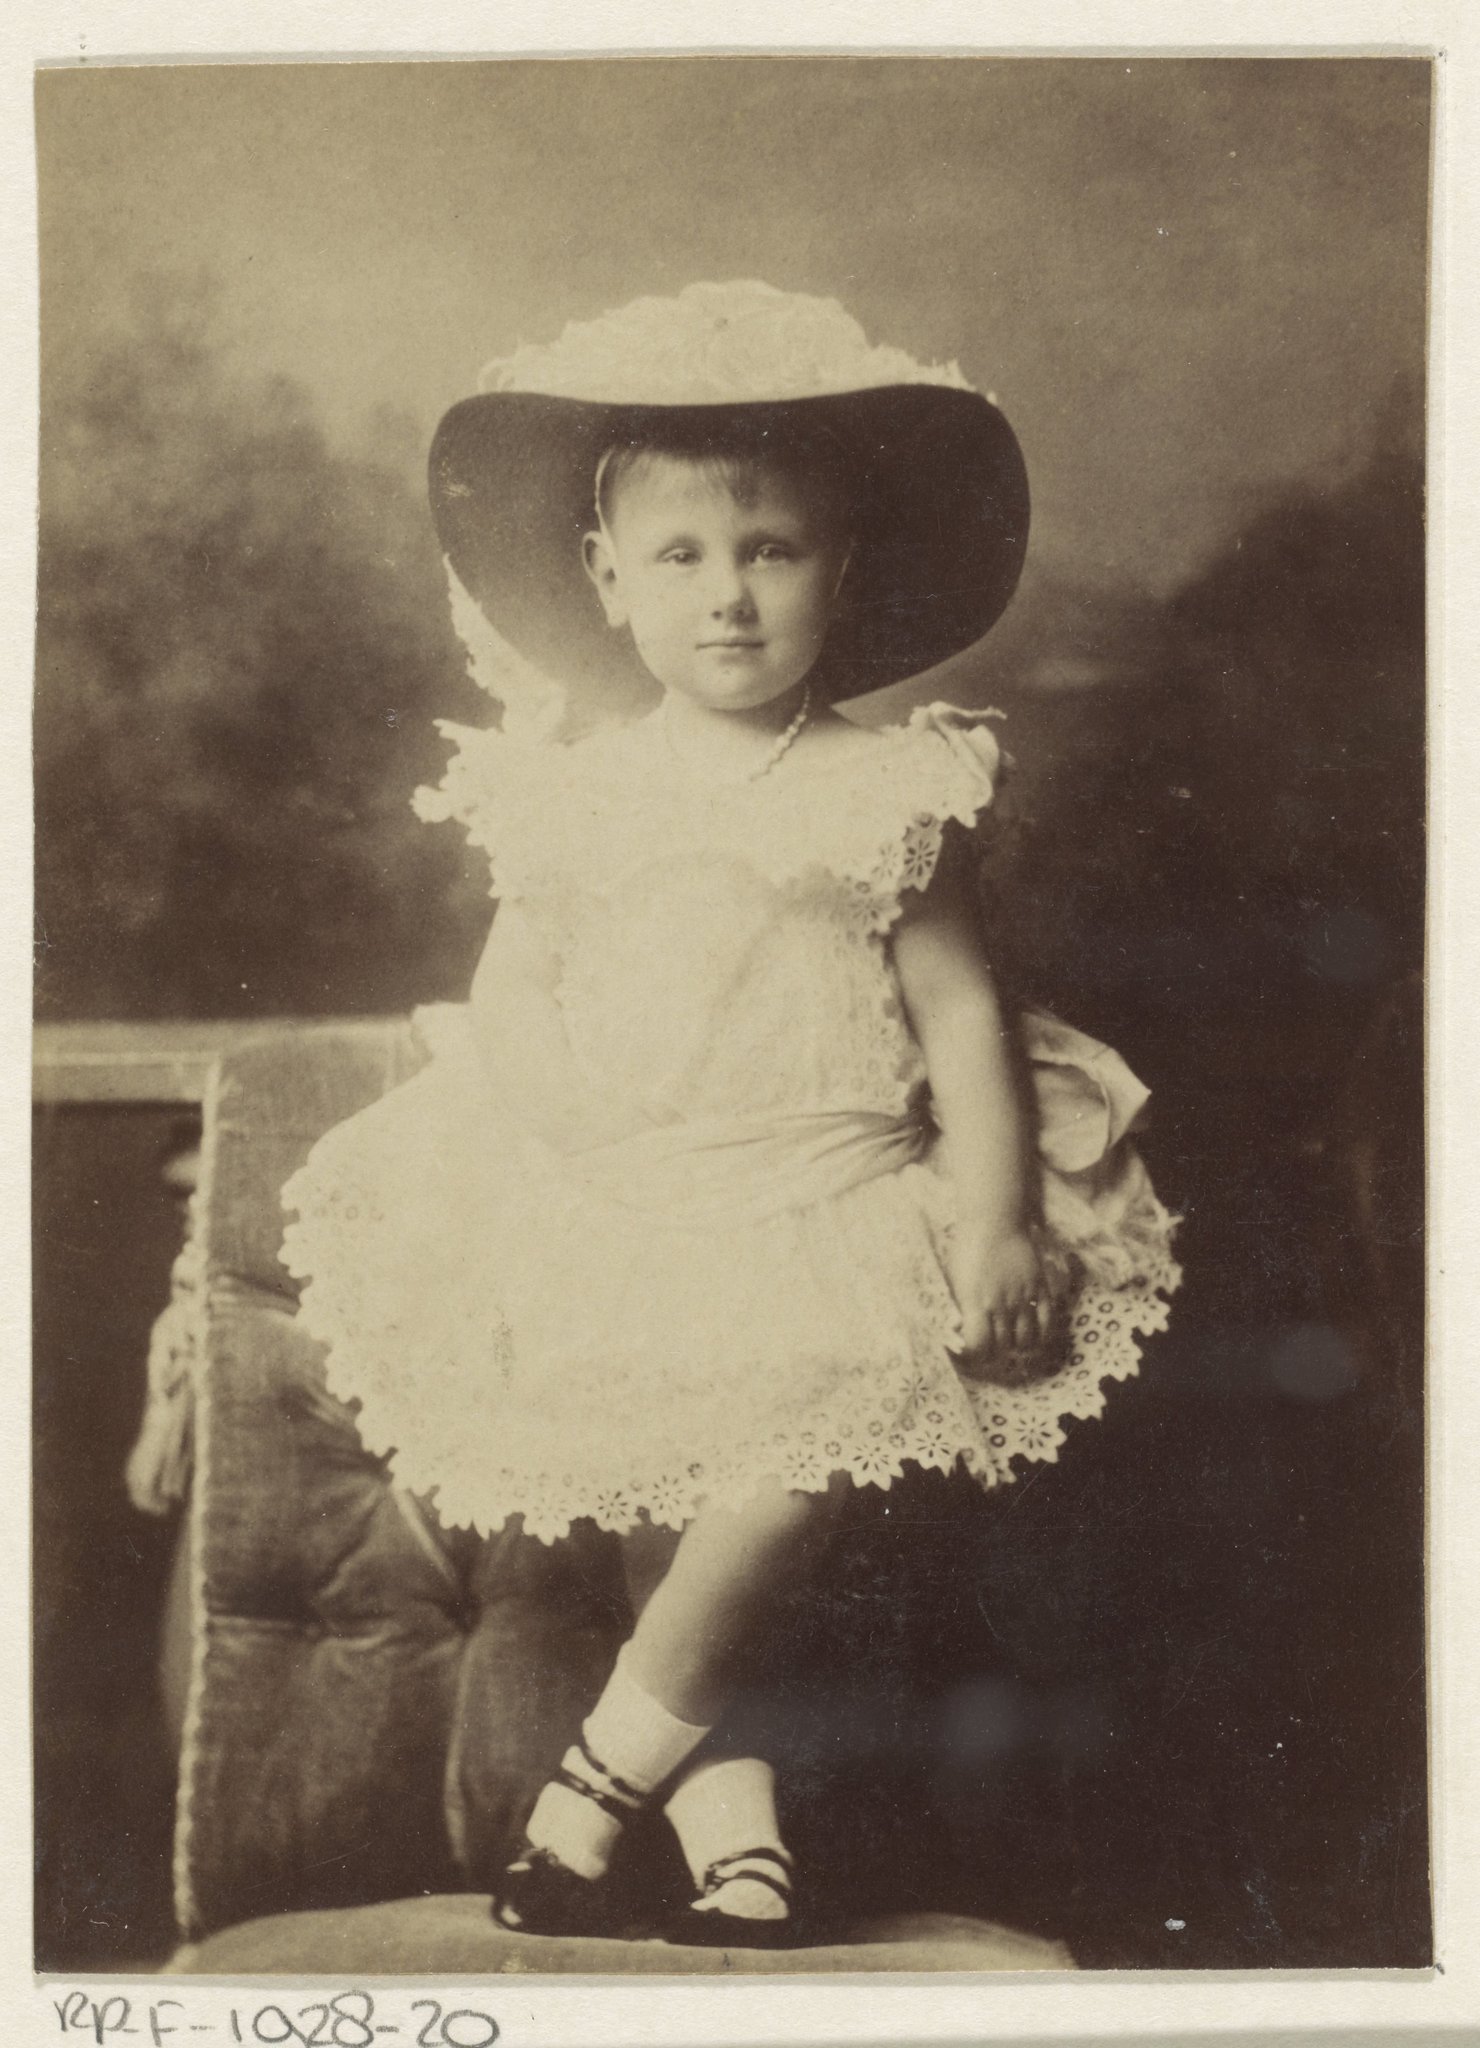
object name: photograph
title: Portret van Wilhelmina, koningin der Nederlanden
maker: Anonymous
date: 1882-1883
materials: paper, photographic support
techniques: albumen print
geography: netherlands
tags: the hague, print maker, wilhelmina of the netherlands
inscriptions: collector's mark: Lugt 2233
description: De hier vermelde titel verwijst naar de hoogst verkregen titel van de geportretteerde, niet per se naar de titel die de geportretteerde op deze voorstelling draagt.